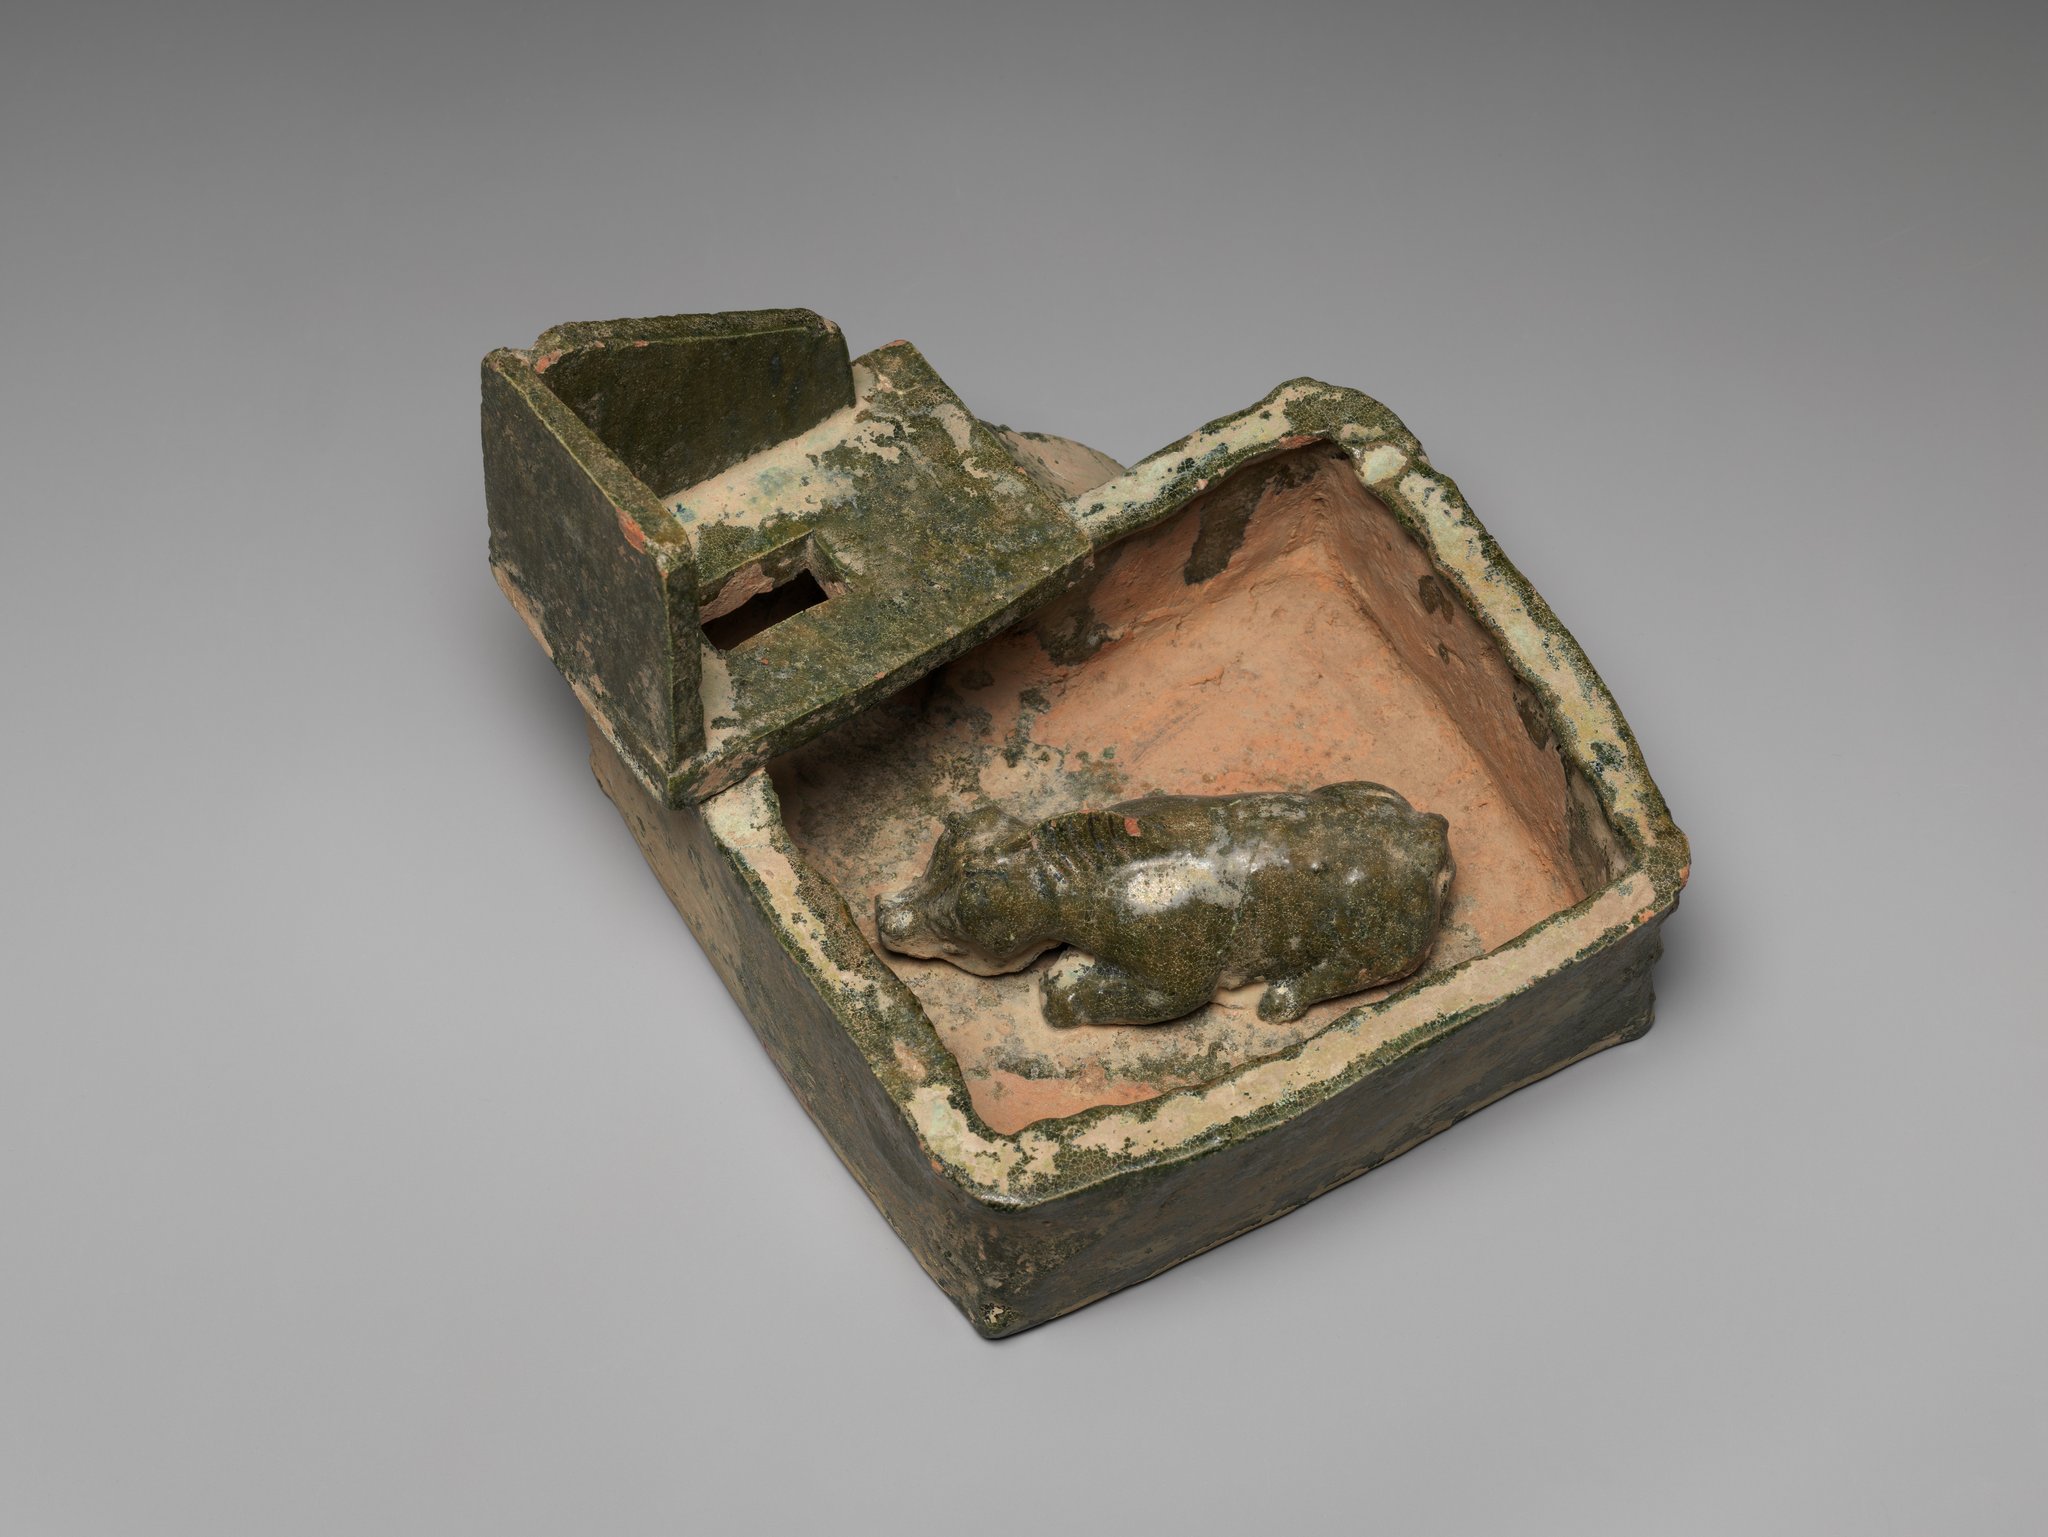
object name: architectural model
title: Pigsty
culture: chinese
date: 1-233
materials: earthenware, glaze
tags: pigs